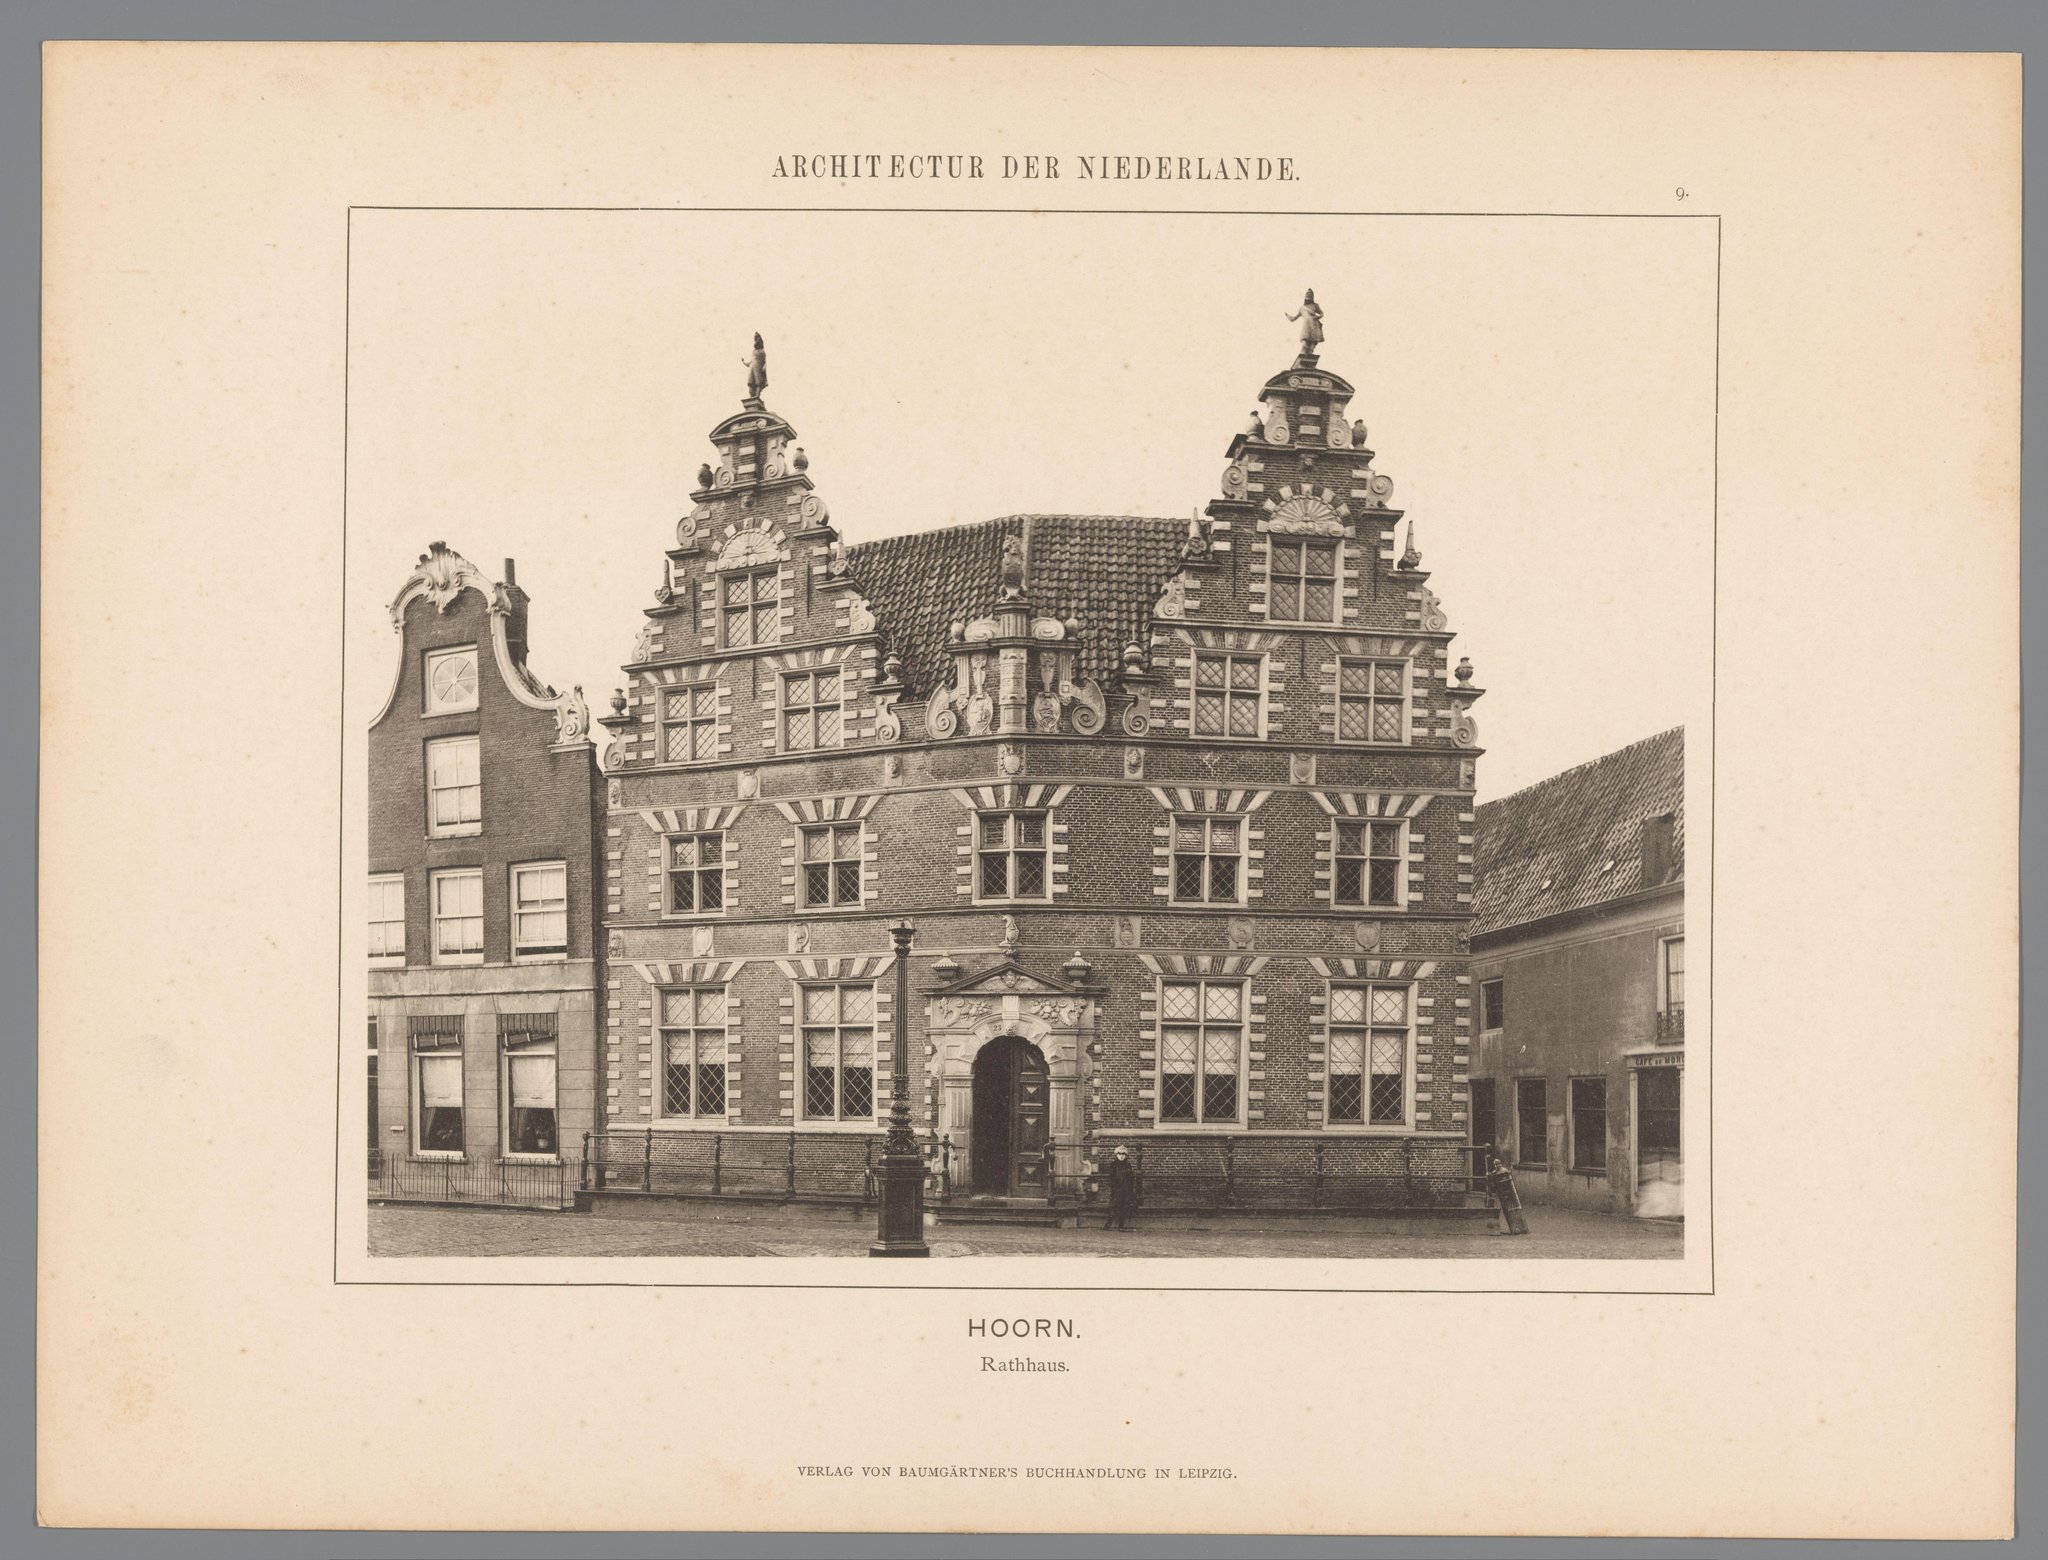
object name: book illustration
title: Gezicht op het oude stadhuis van Hoorn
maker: Anonymous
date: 1894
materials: paper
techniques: photograph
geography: leipzig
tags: townhall, hoorn (north holland)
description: Afdruk uit: Krook, L. Architectur der Niederlande. Leipzig: Baumgärtner's Buchhandlung, 1894.